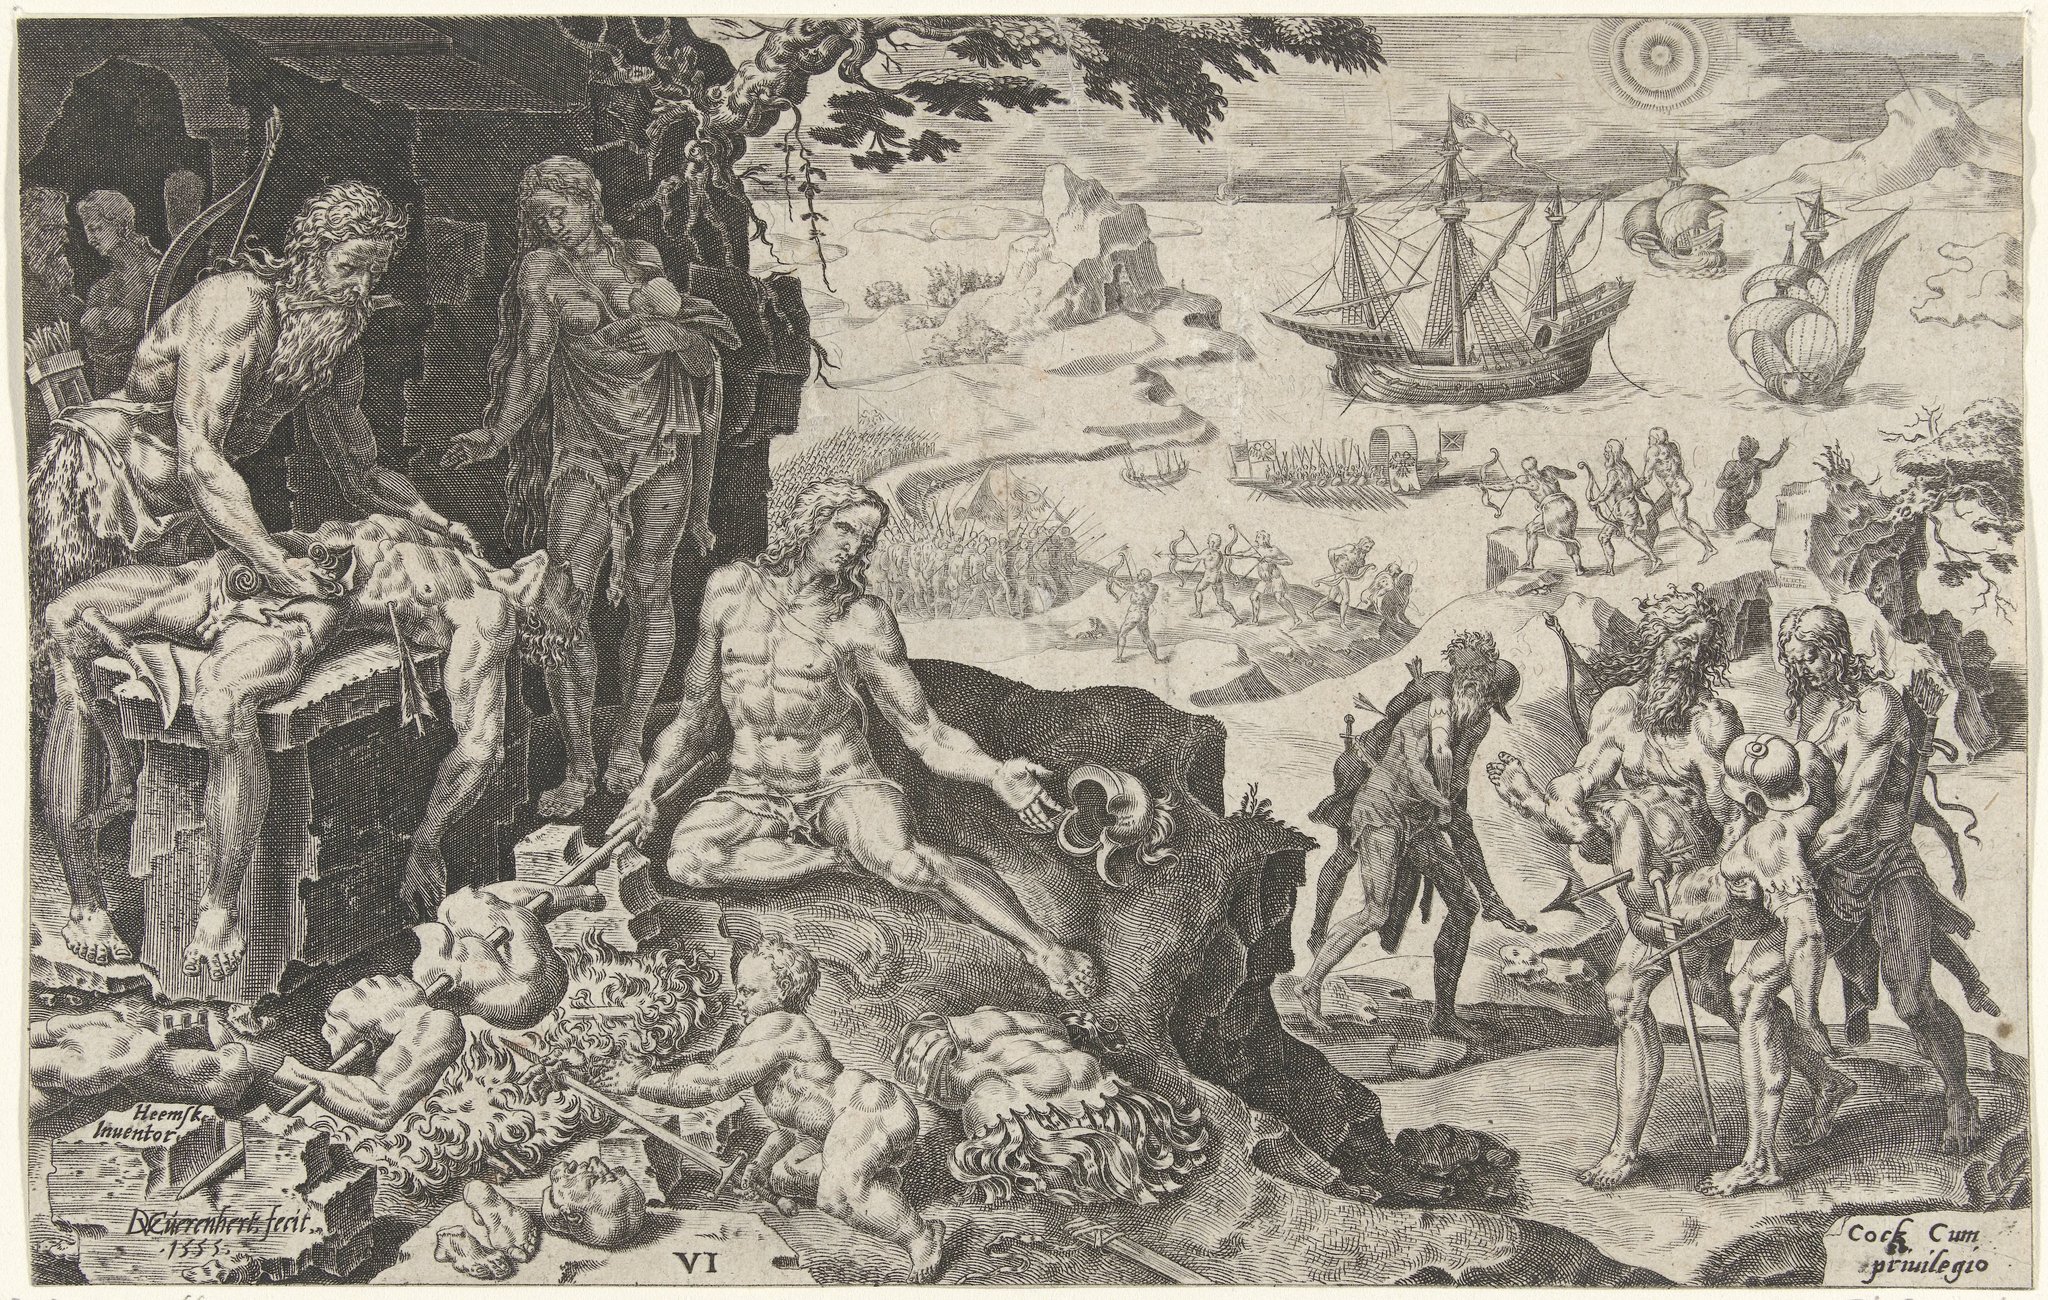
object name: history print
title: Beschaving wordt gebracht bij de Indianen, 1530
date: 1555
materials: paper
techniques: engraving, etching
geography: antwerp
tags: ghent, charles v (holy roman emperor and king of spain), battle, indigenous peoples of central america, violent death by disembowelment, pulling out of intestines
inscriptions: collector's mark: Lugt 2228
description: Keizerlijke troepen van Karel V vallen Centraal-Amerika binnen, 1530. De oorspronkelijke bevolking van toenmalig Nieuw-Spanje, nu Mexico, bedrijft kannibalisme. Op de voorgrond wordt links een Spaanse soldaat ontdaan van zijn organen en worden ledematen van andere soldaten geroosterd . Rechts worden nog twee gedode soldaten naar die plek gebracht. Op de achtergrond vechten Spaanse soldaten en de lokale bevolking een veldslag uit. De prent maakt deel uit van een twaalfdelige serie over overwinningen van Karel V.